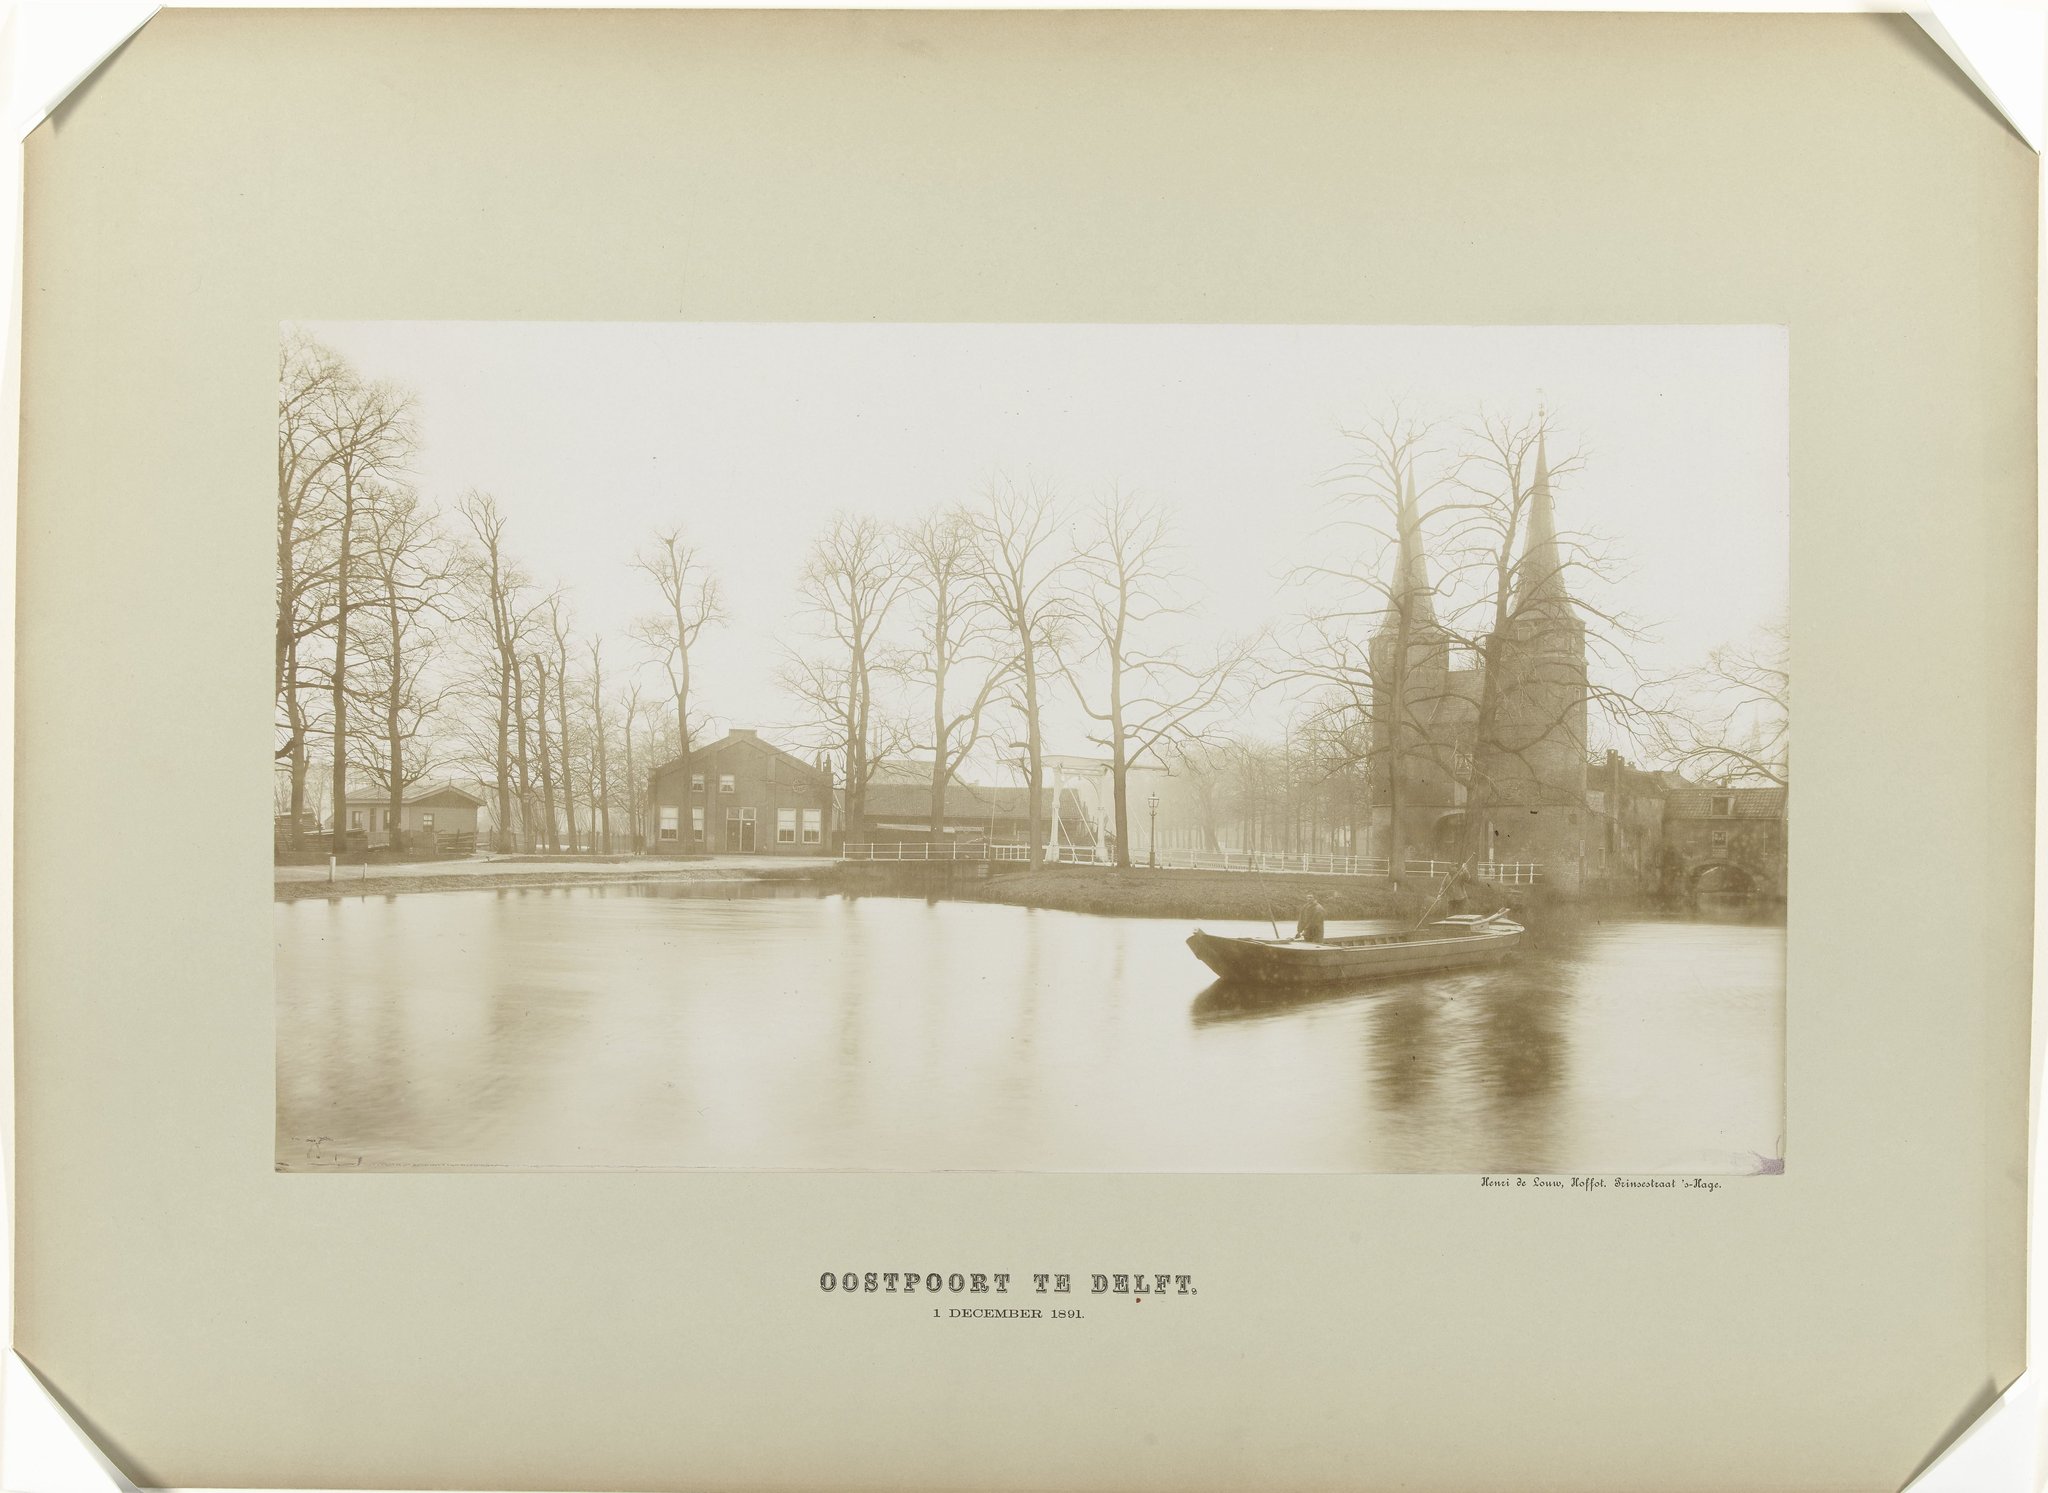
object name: photograph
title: Oostpoort te Delft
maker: henri de louw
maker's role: fotograaf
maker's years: 1851-1944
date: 1891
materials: cardboard, photographic support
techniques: collodion silver print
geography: the hague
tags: oostpoort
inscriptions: date